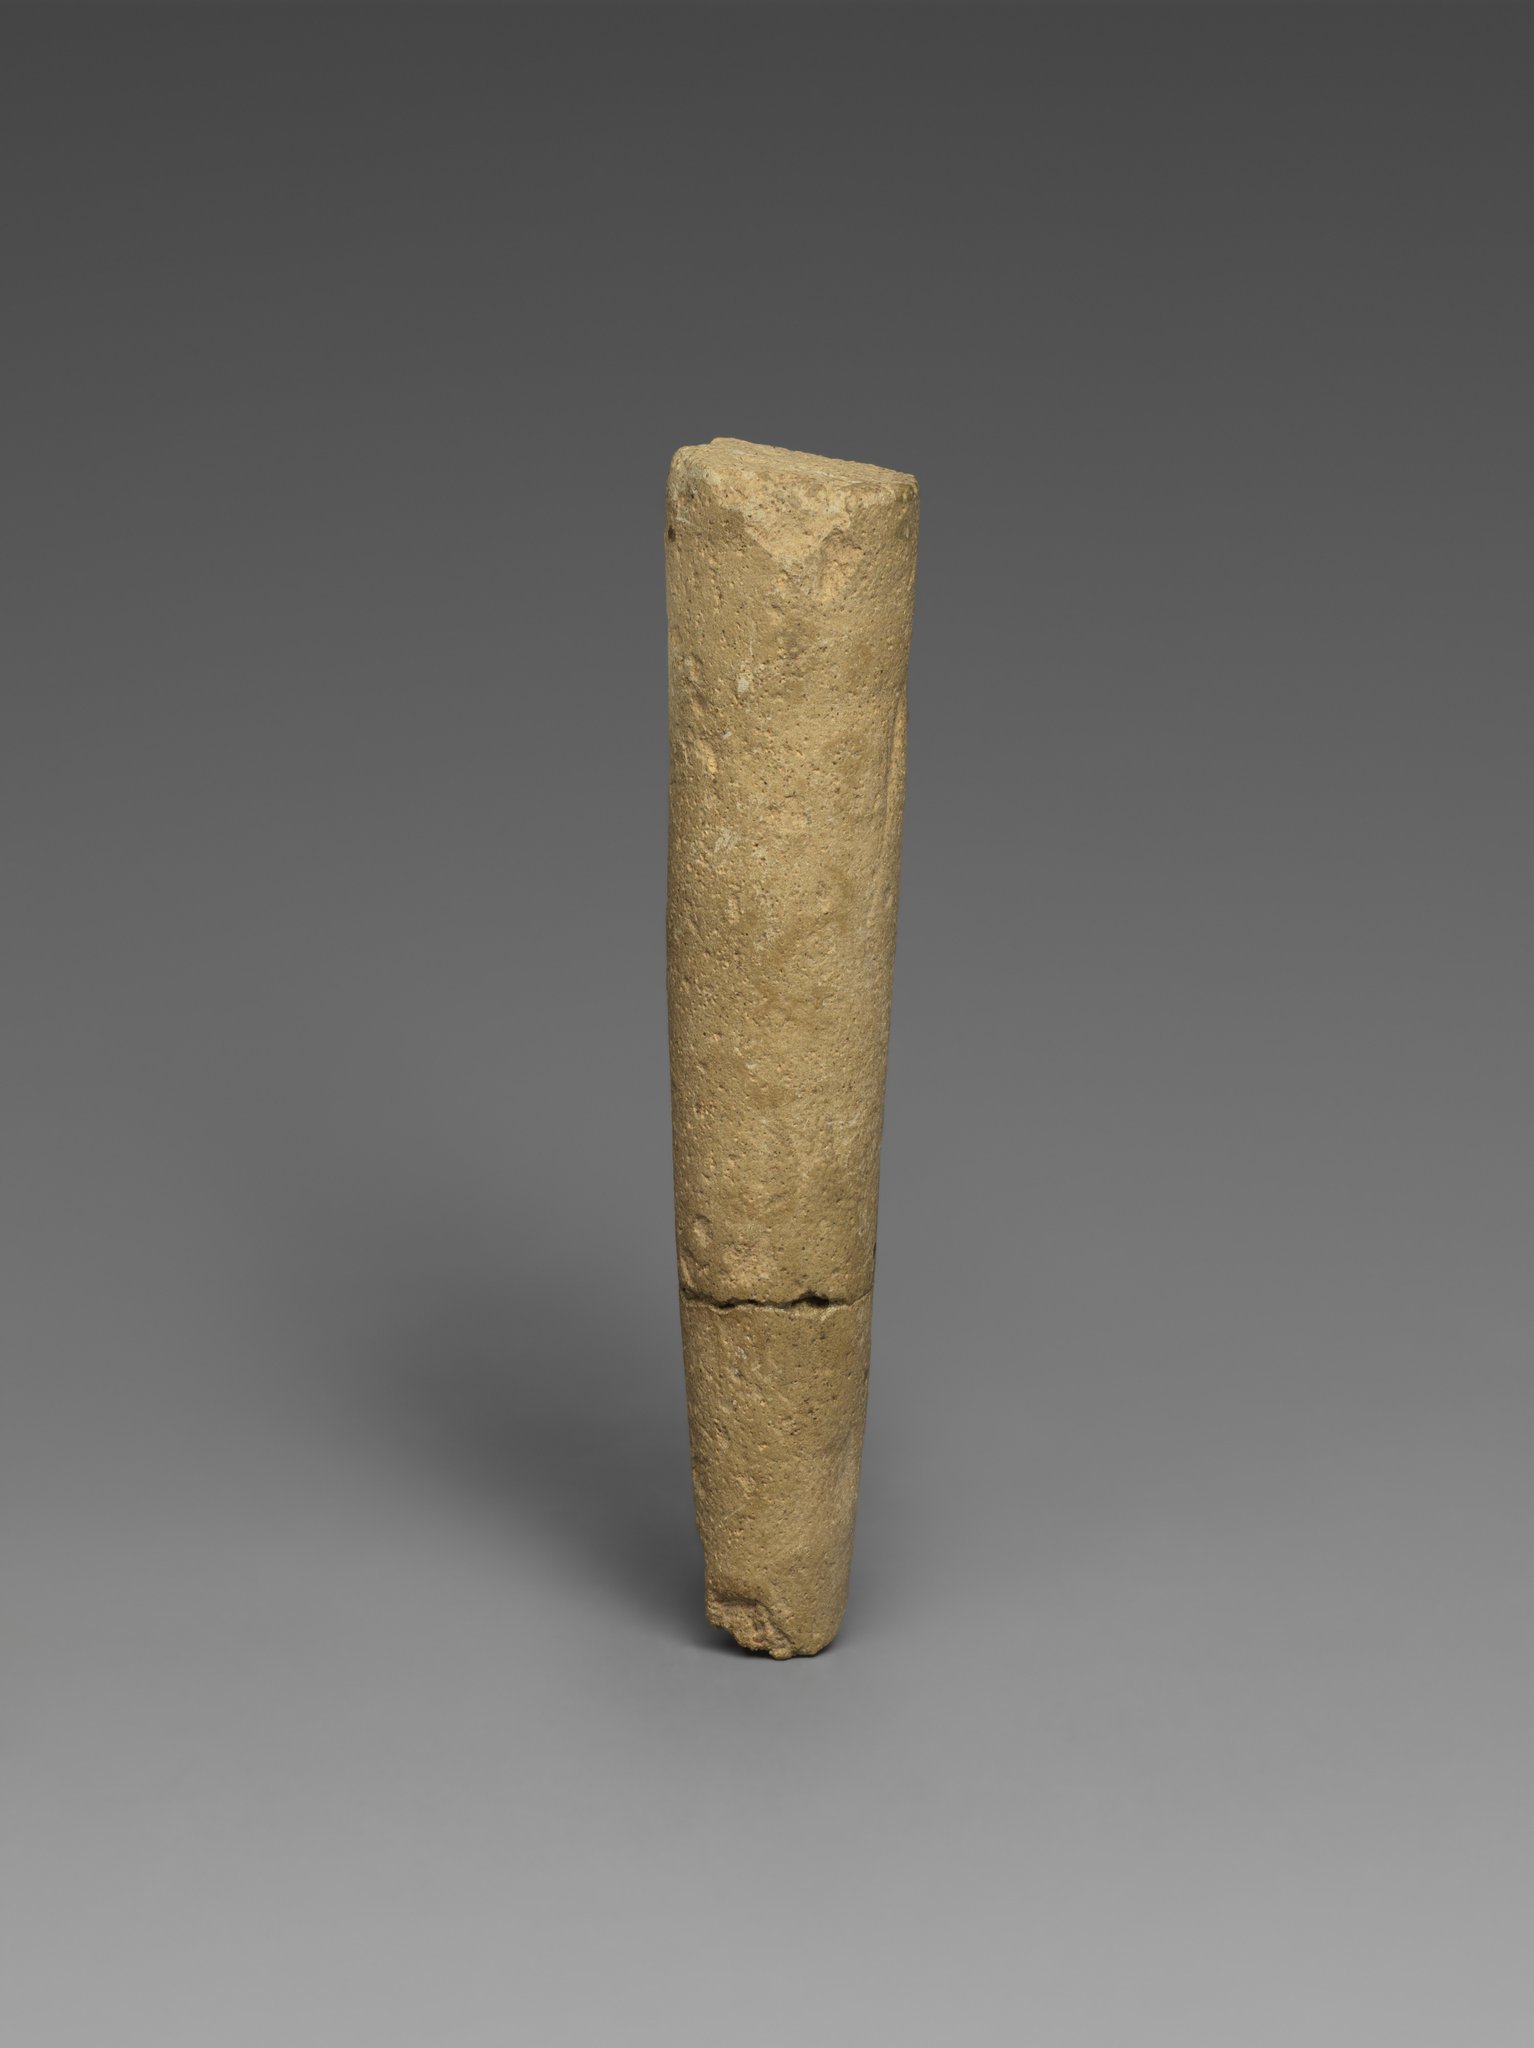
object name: mosaic cone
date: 3100-2900 BCE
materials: ceramic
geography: mesopotamia